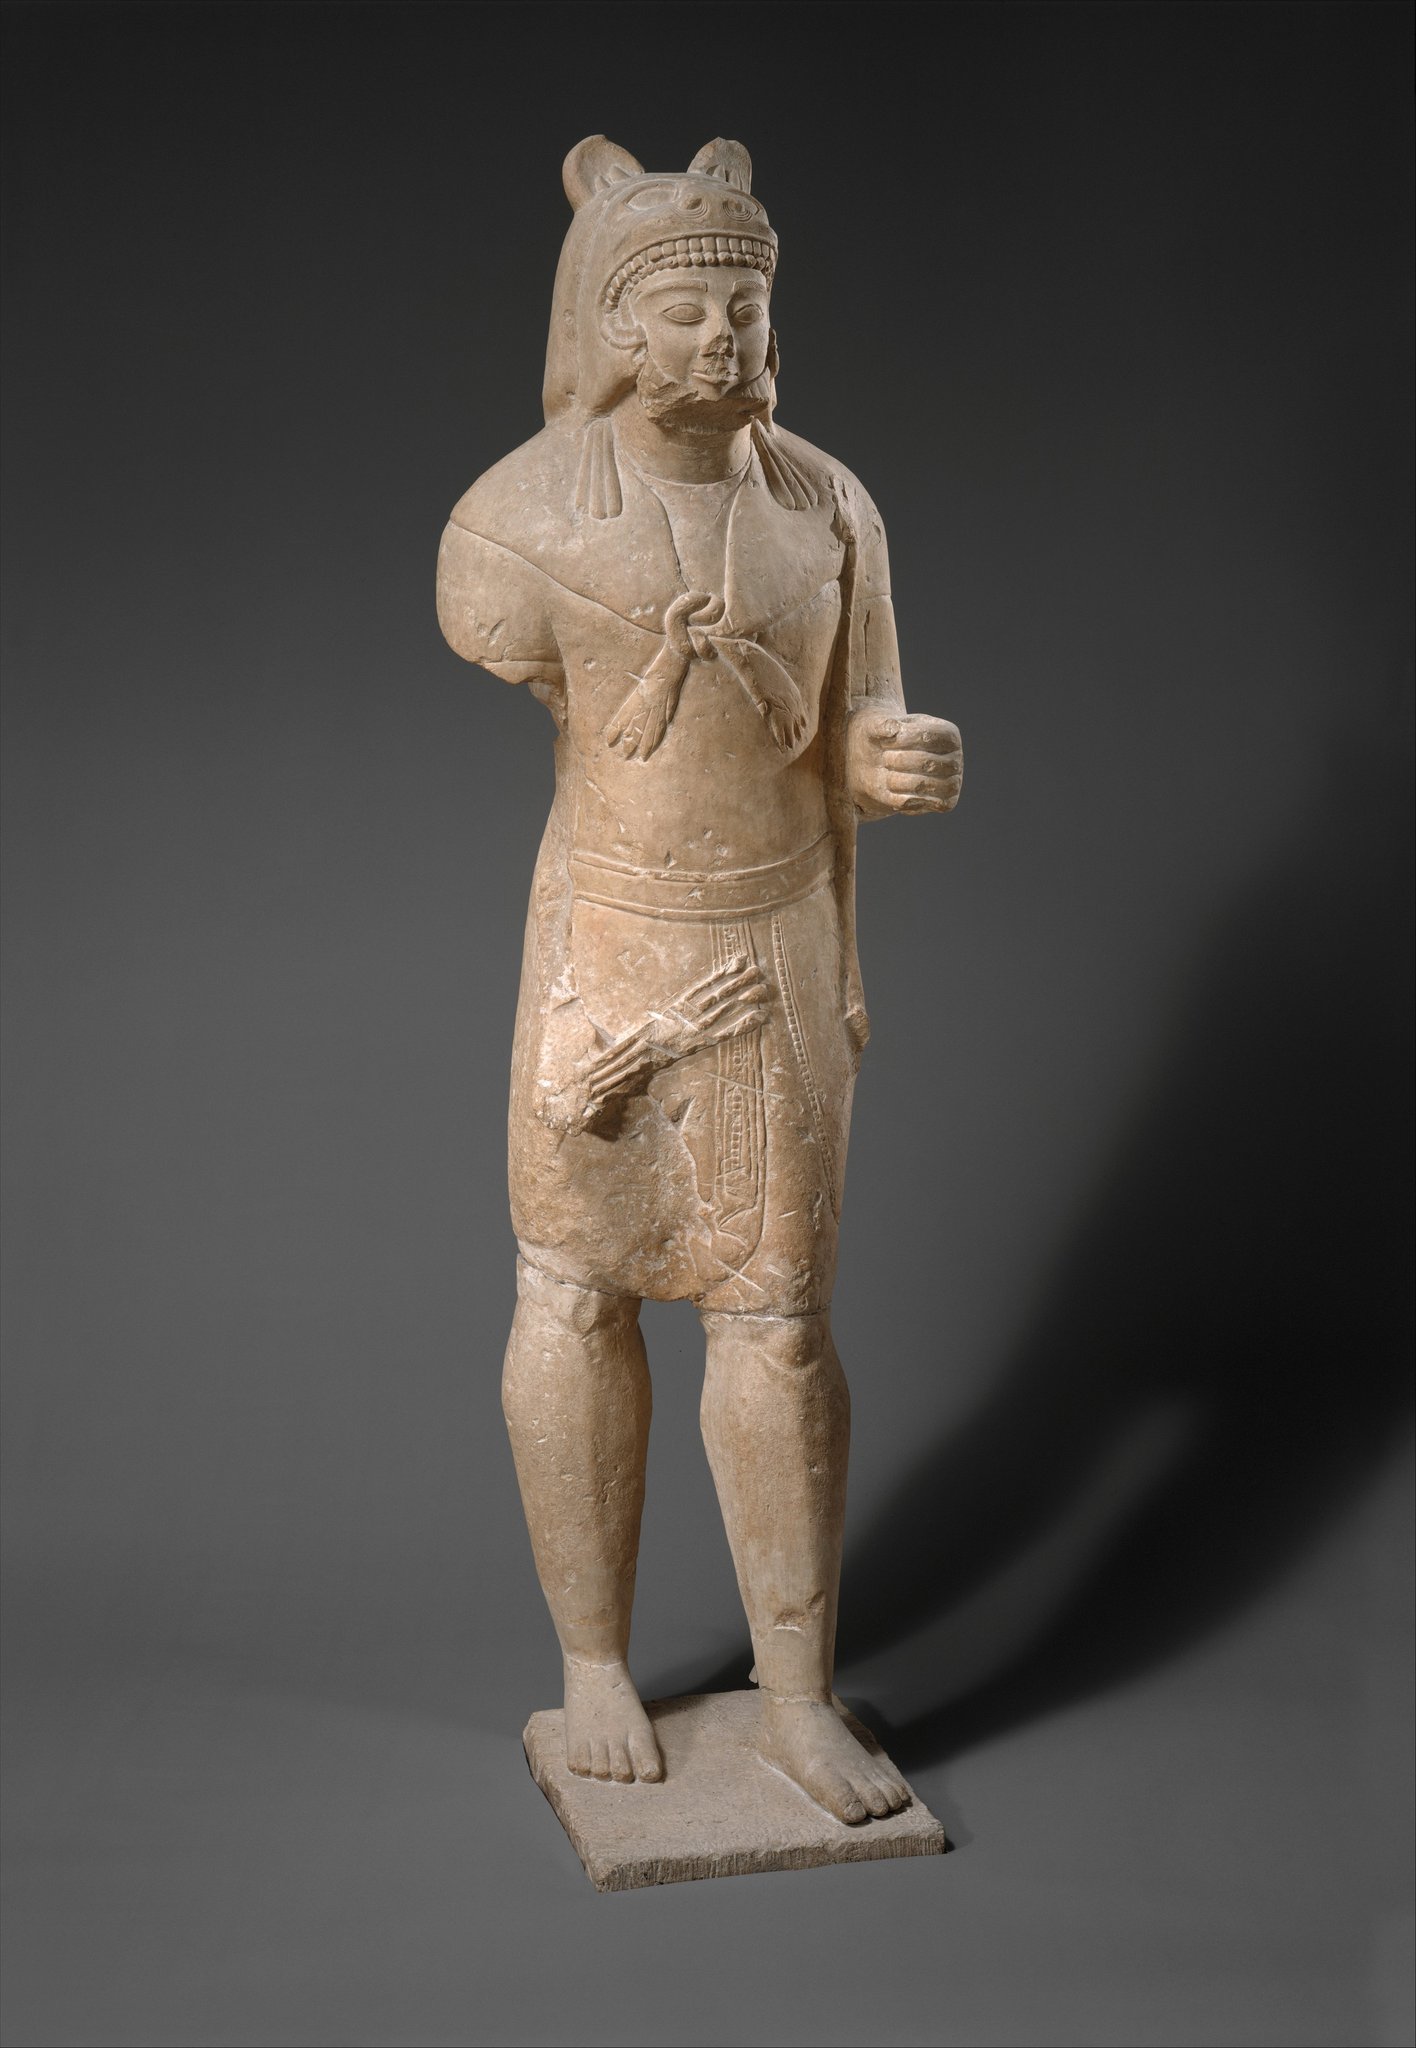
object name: statue of herakles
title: Limestone Herakles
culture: cypriot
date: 530-520 BCE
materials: limestone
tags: men,herakles